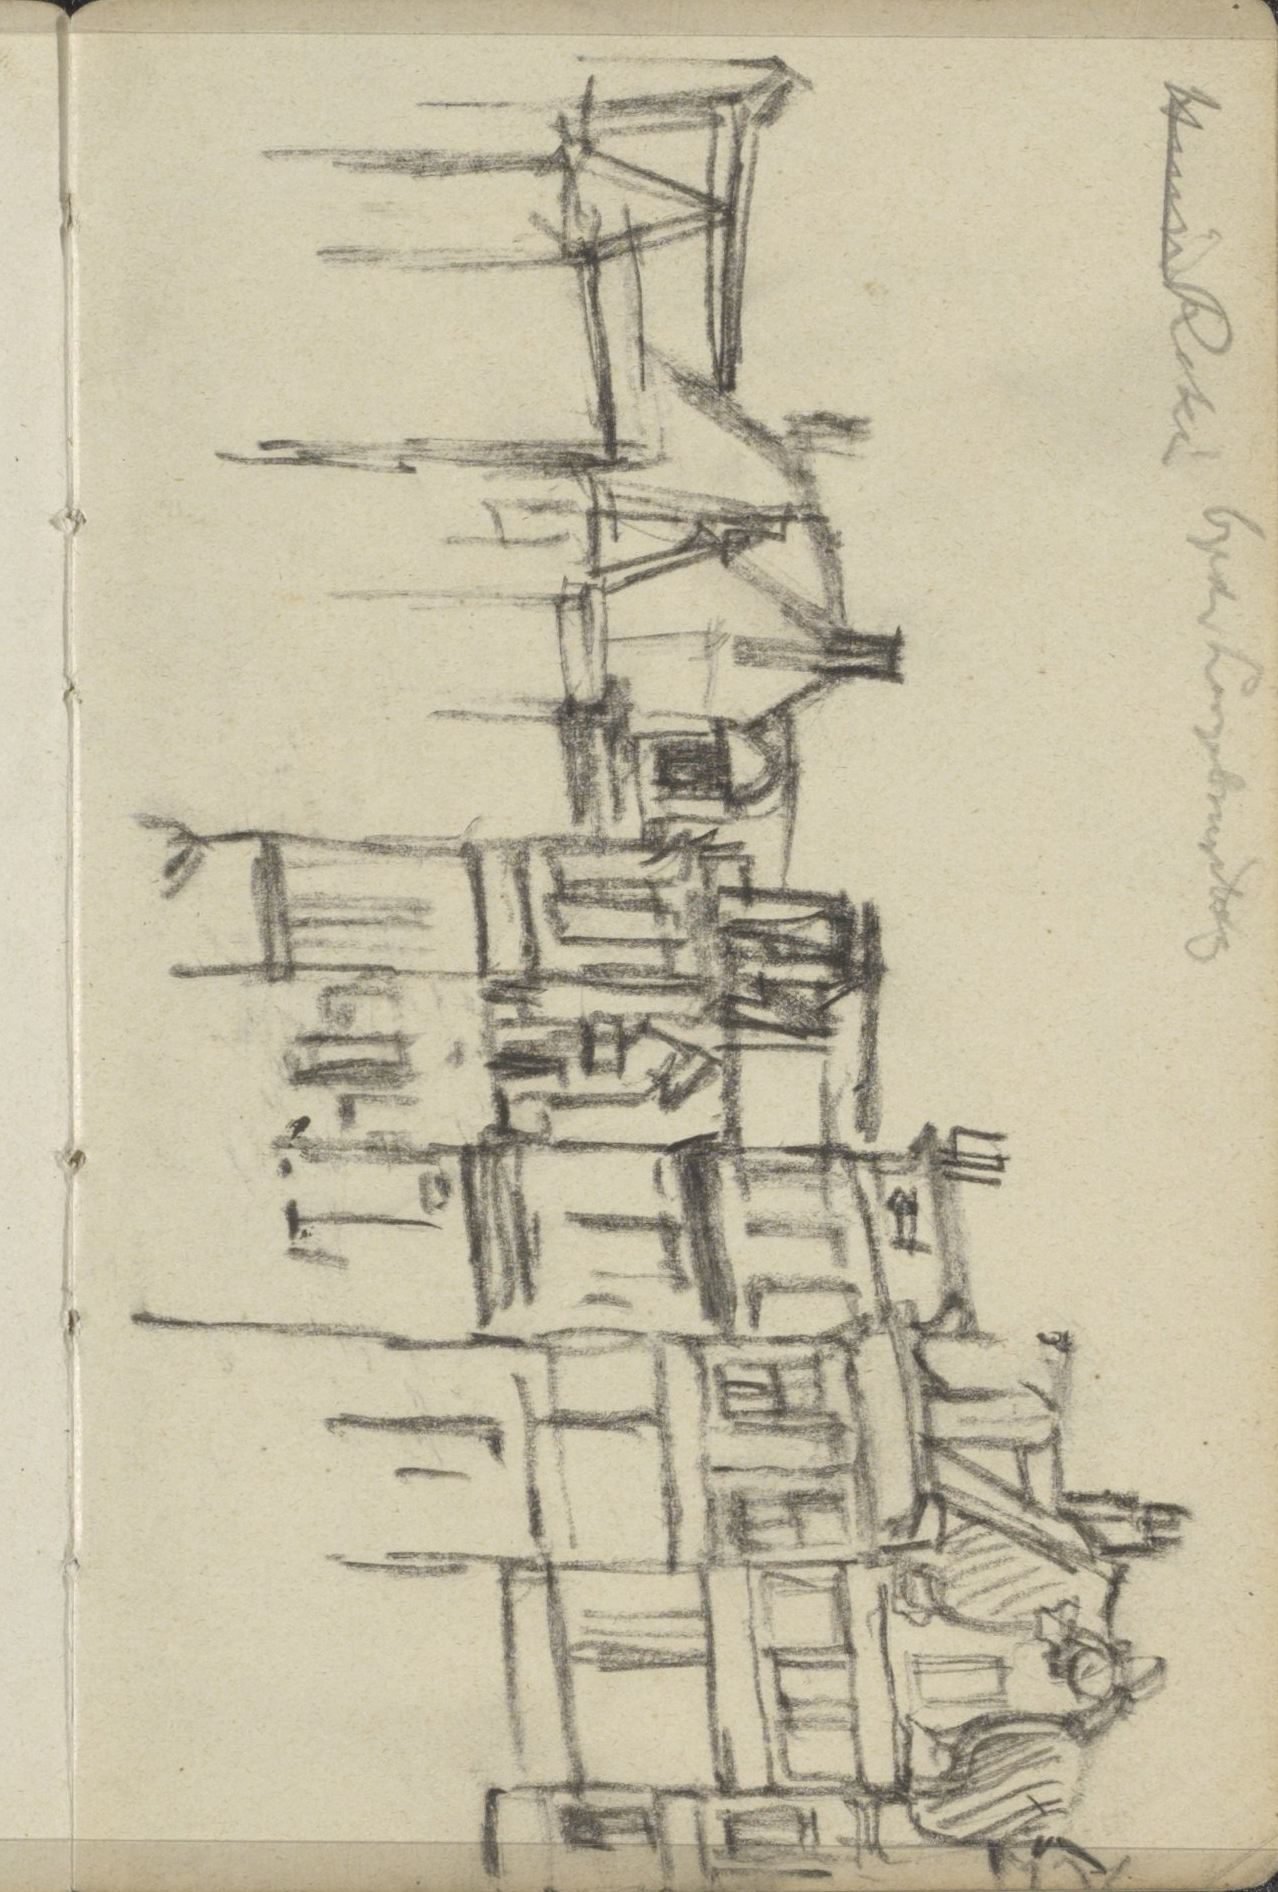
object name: sketchbook leaf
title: Gezicht op het Rokin in Amsterdam ter hoogte van de Langebrugsteeg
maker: george hendrik breitner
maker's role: draughtsman, painter, print maker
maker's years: 1857-1923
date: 1910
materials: chalk, paper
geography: amsterdam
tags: civic architecture; edifices; dwellings, street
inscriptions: annotation: ‘Rokin bij de Langebrugsteeg’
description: Pagina 80 uit een schetsboek met 45 bladen.